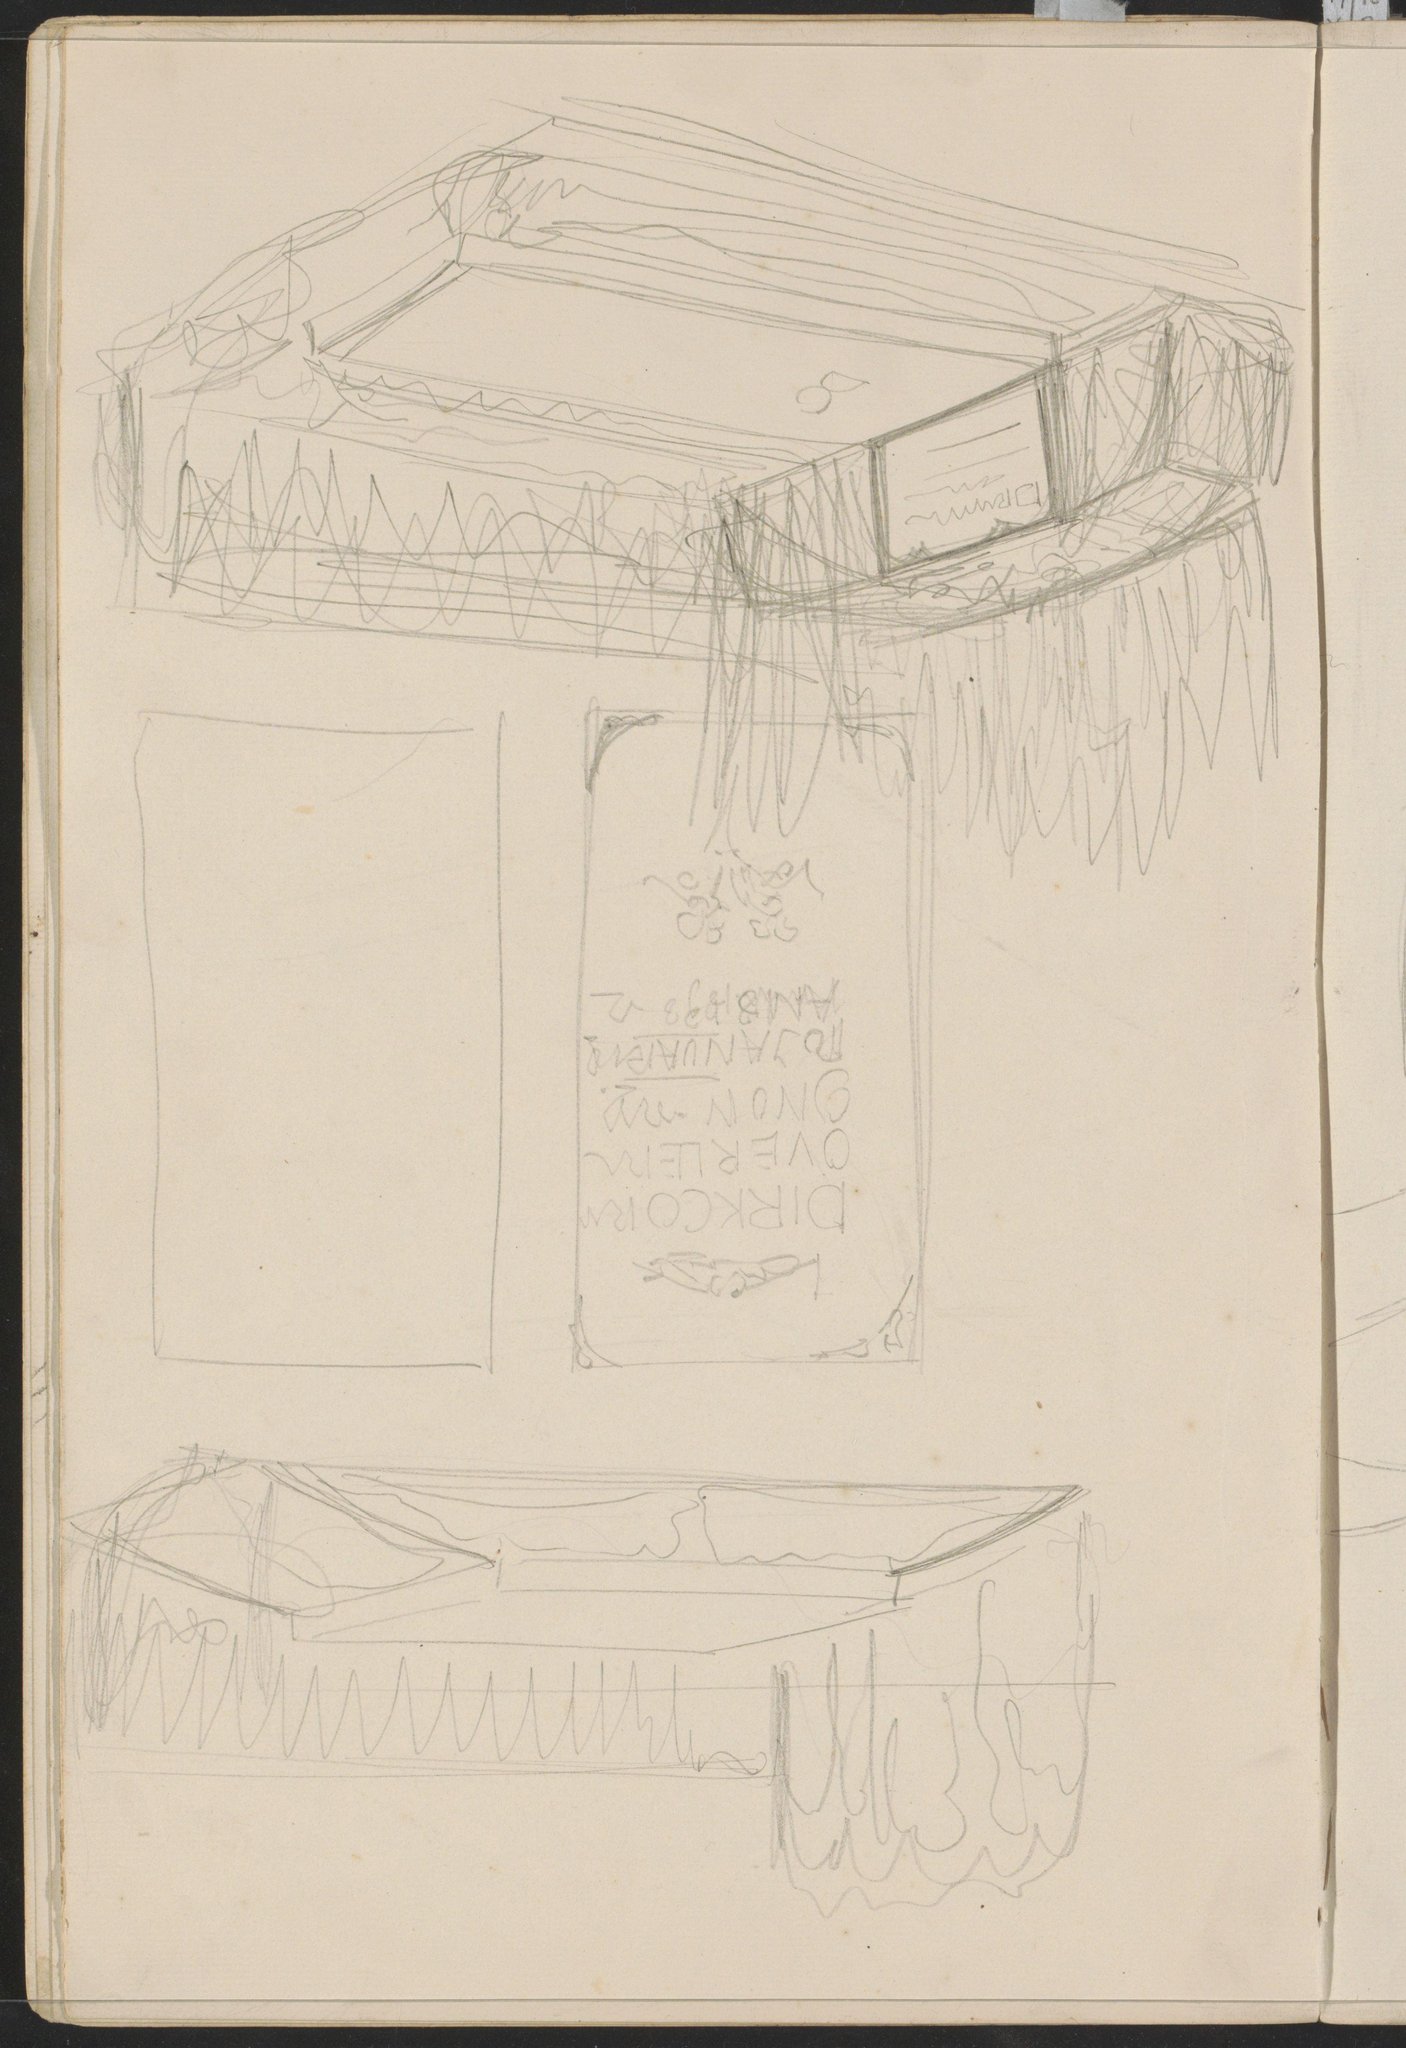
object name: sketchbook leaf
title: Graf en een grafsteen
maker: carel adolph lion cachet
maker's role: draughtsman, print maker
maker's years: 1864-1945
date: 1897-1898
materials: paper, pencil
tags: grave, tomb, gravestone, tombstone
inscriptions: annotation: ‘DIRKCORM/OVERLE[...]/ 9 NO[...]/ [...] JANUAR[...]’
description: Blad 12 verso uit een schetsboek met 29 bladen.